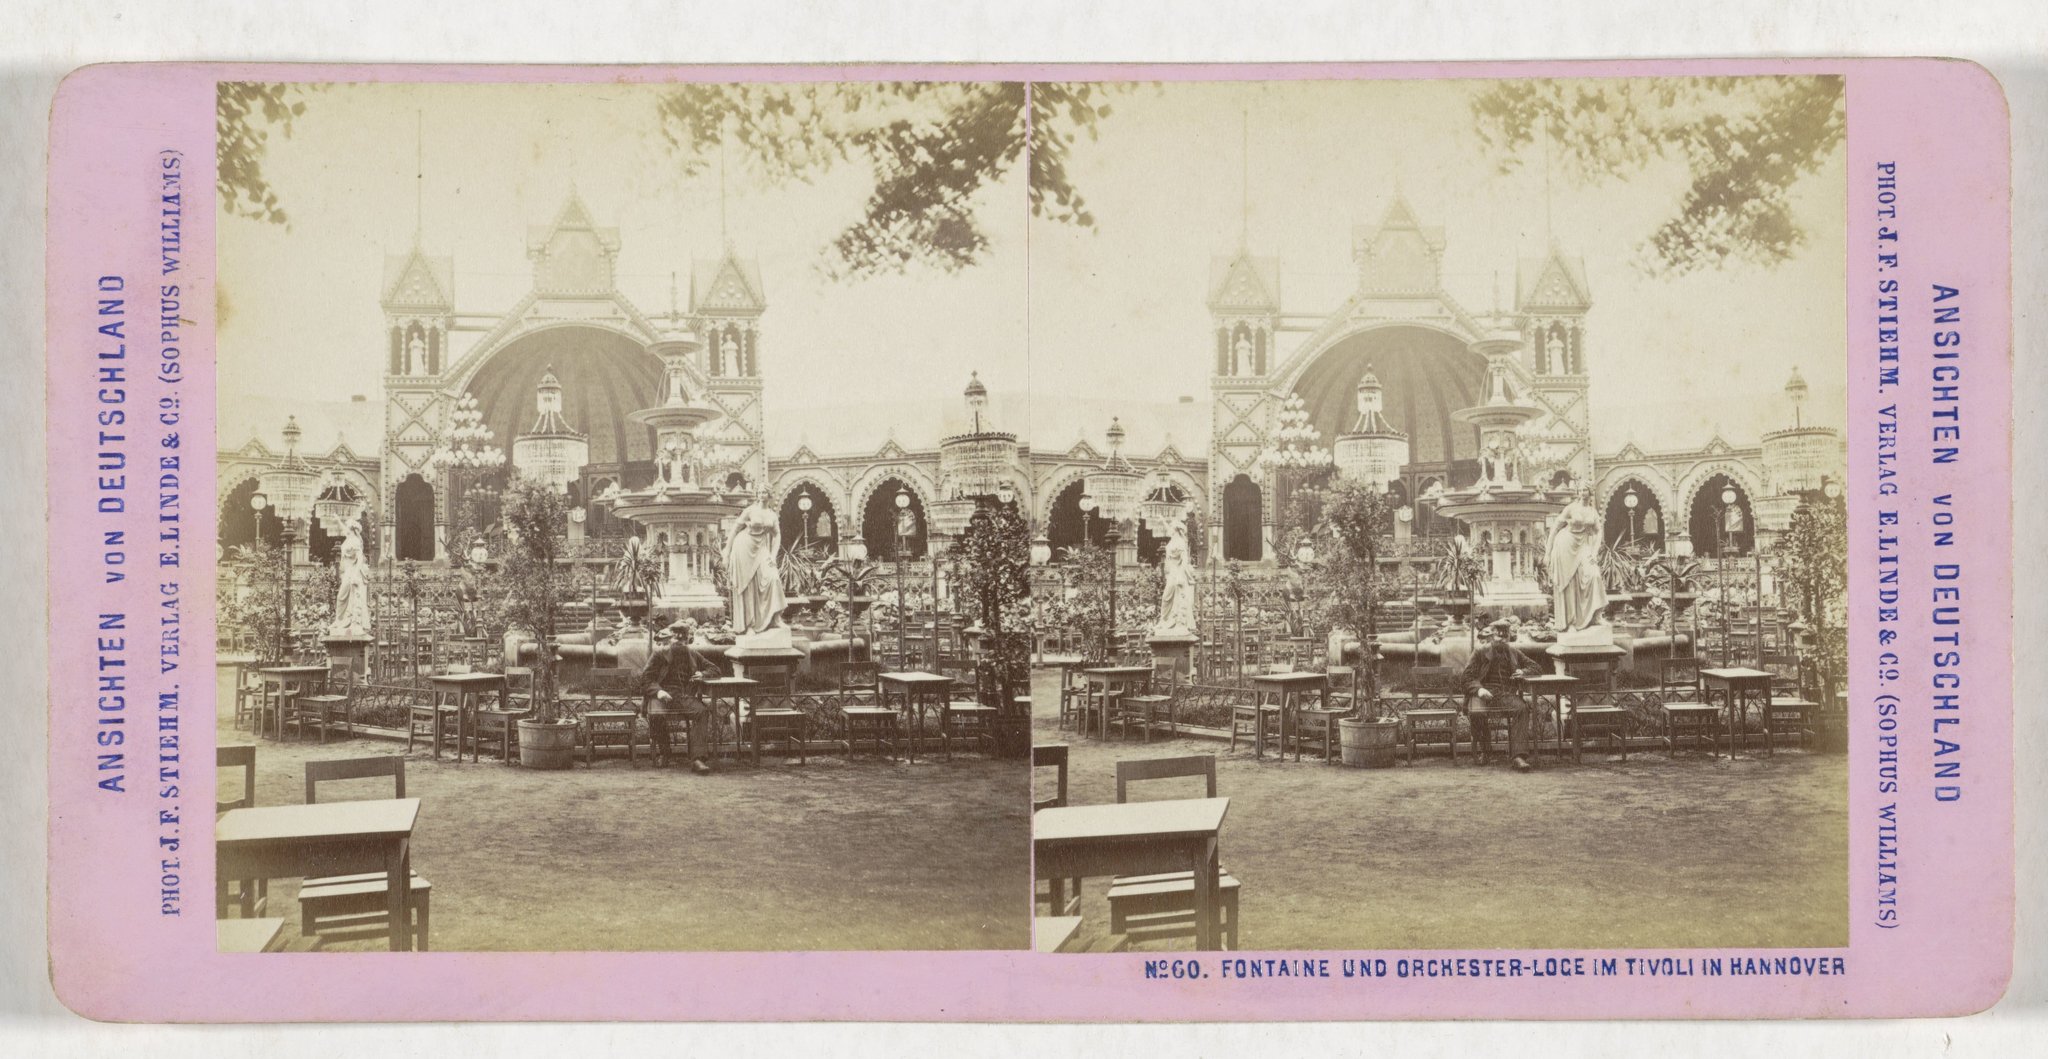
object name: stereograph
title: Fontaine und Orchester-Loge im Tivoli in Hannover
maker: johann friedrich stiehm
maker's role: fotograaf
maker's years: 1826-1902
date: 1869-1872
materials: cardboard, paper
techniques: albumen print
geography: berlin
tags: park, bandstand, garden fountain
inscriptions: number: ‘No 60.’